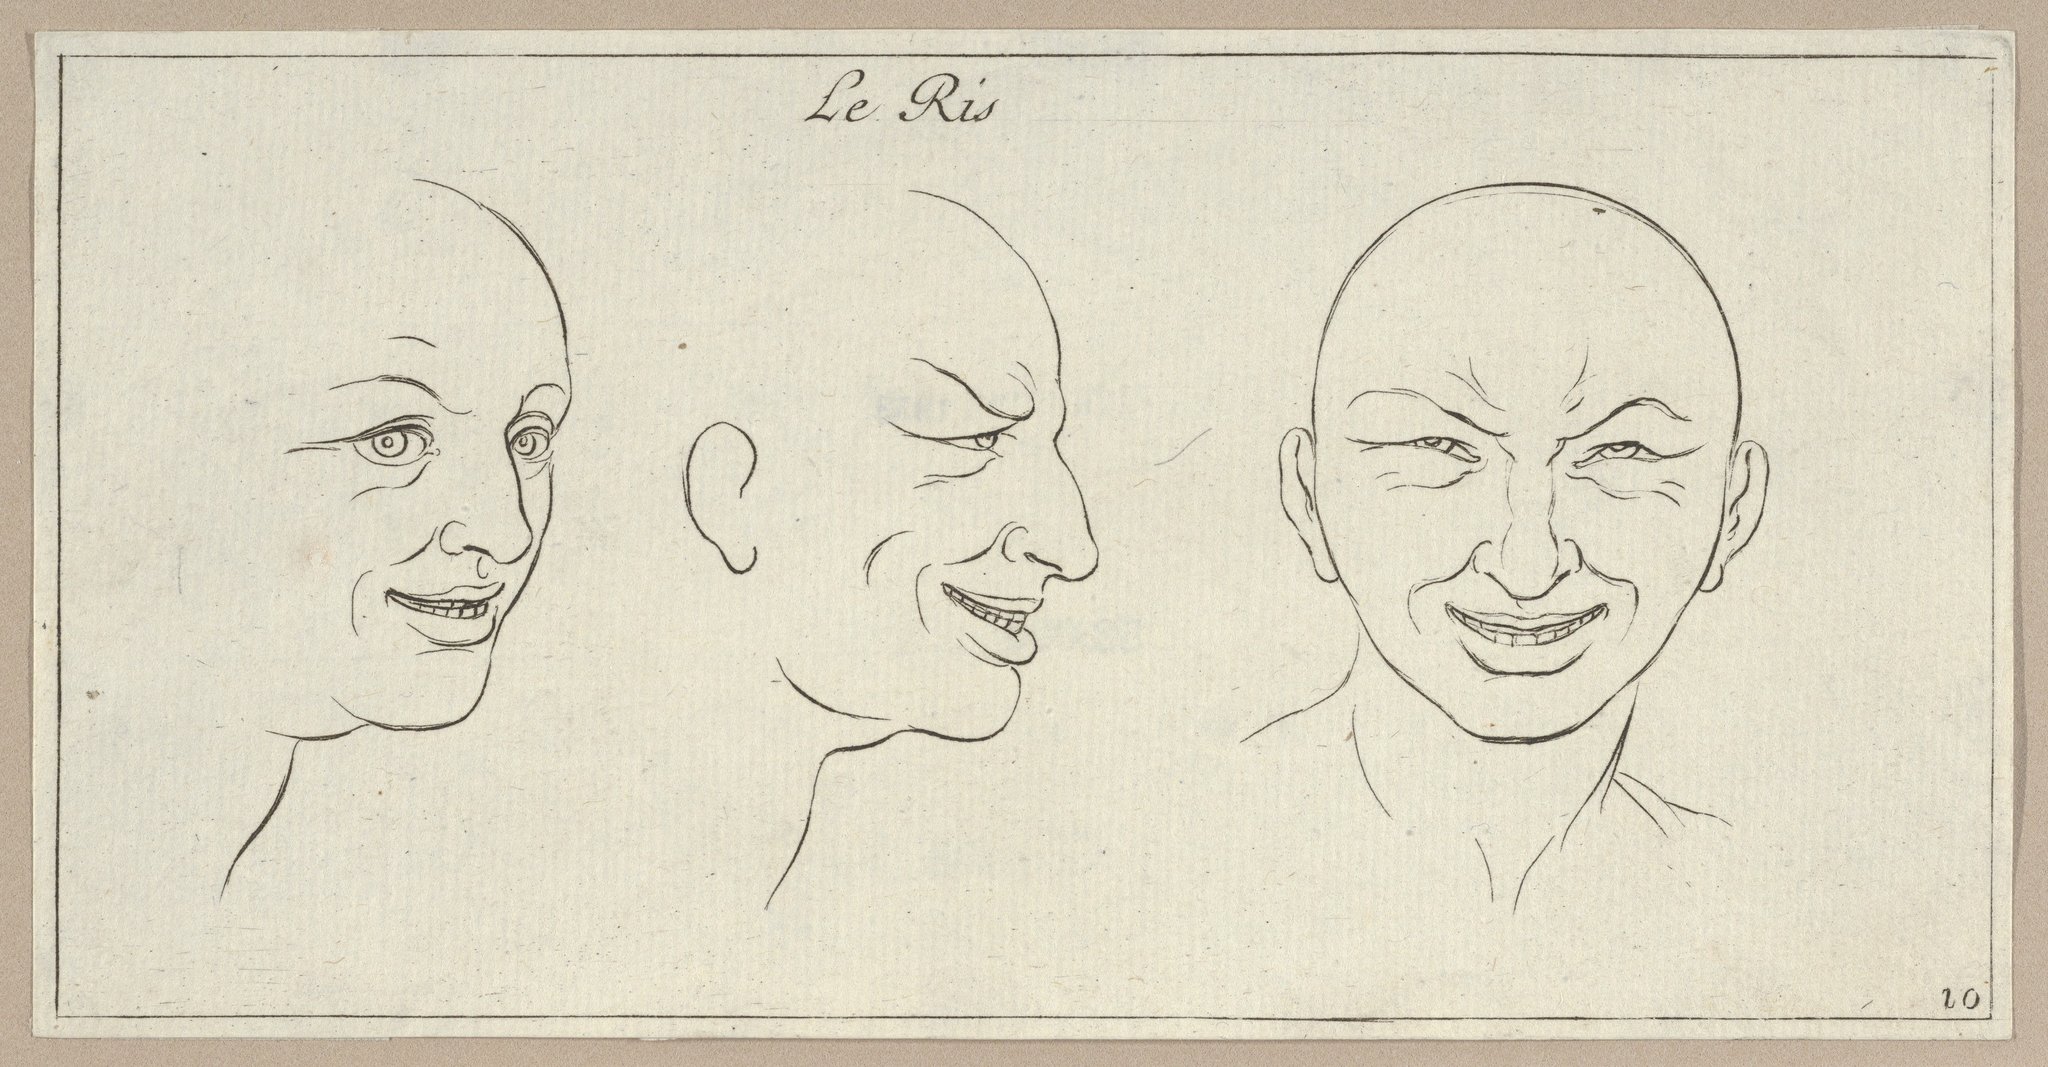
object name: print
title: Le Ris, from "Caractères des passions, gravés sur les desseins de l'illustre Monsieur le Brun"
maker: sébastien le clerc, le jeune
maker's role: etcher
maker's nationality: french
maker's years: 1676-1763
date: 1695-1720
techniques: etching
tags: faces,men